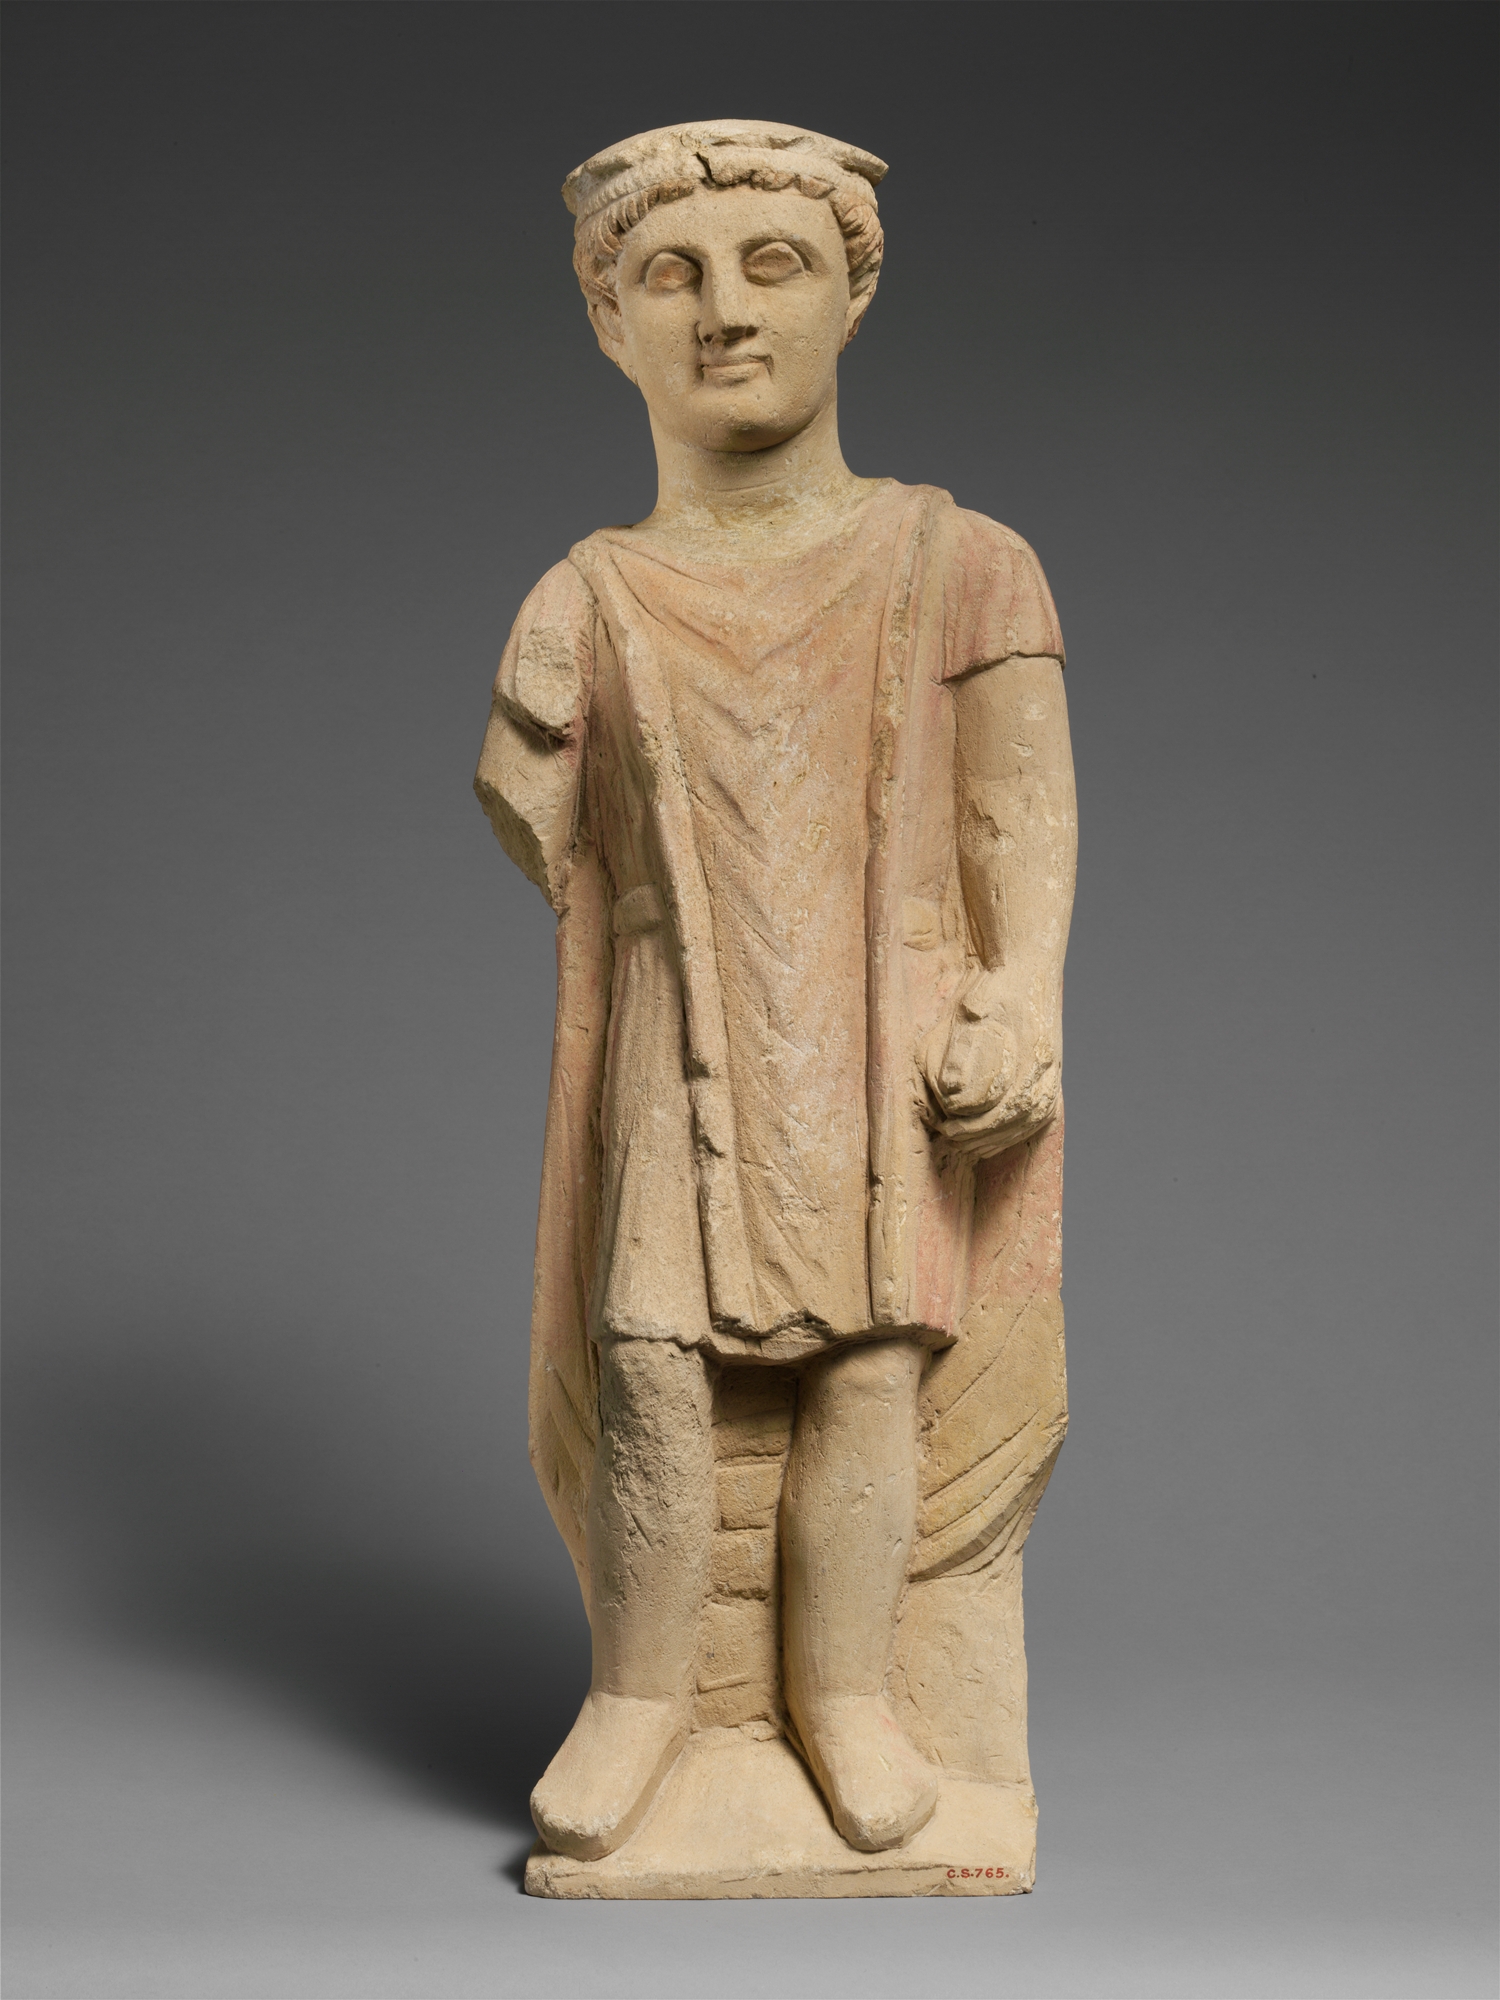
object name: statue of a votary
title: Limestone statuette of a boy holding a pyxis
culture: cypriot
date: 334-1 BCE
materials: limestone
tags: boys